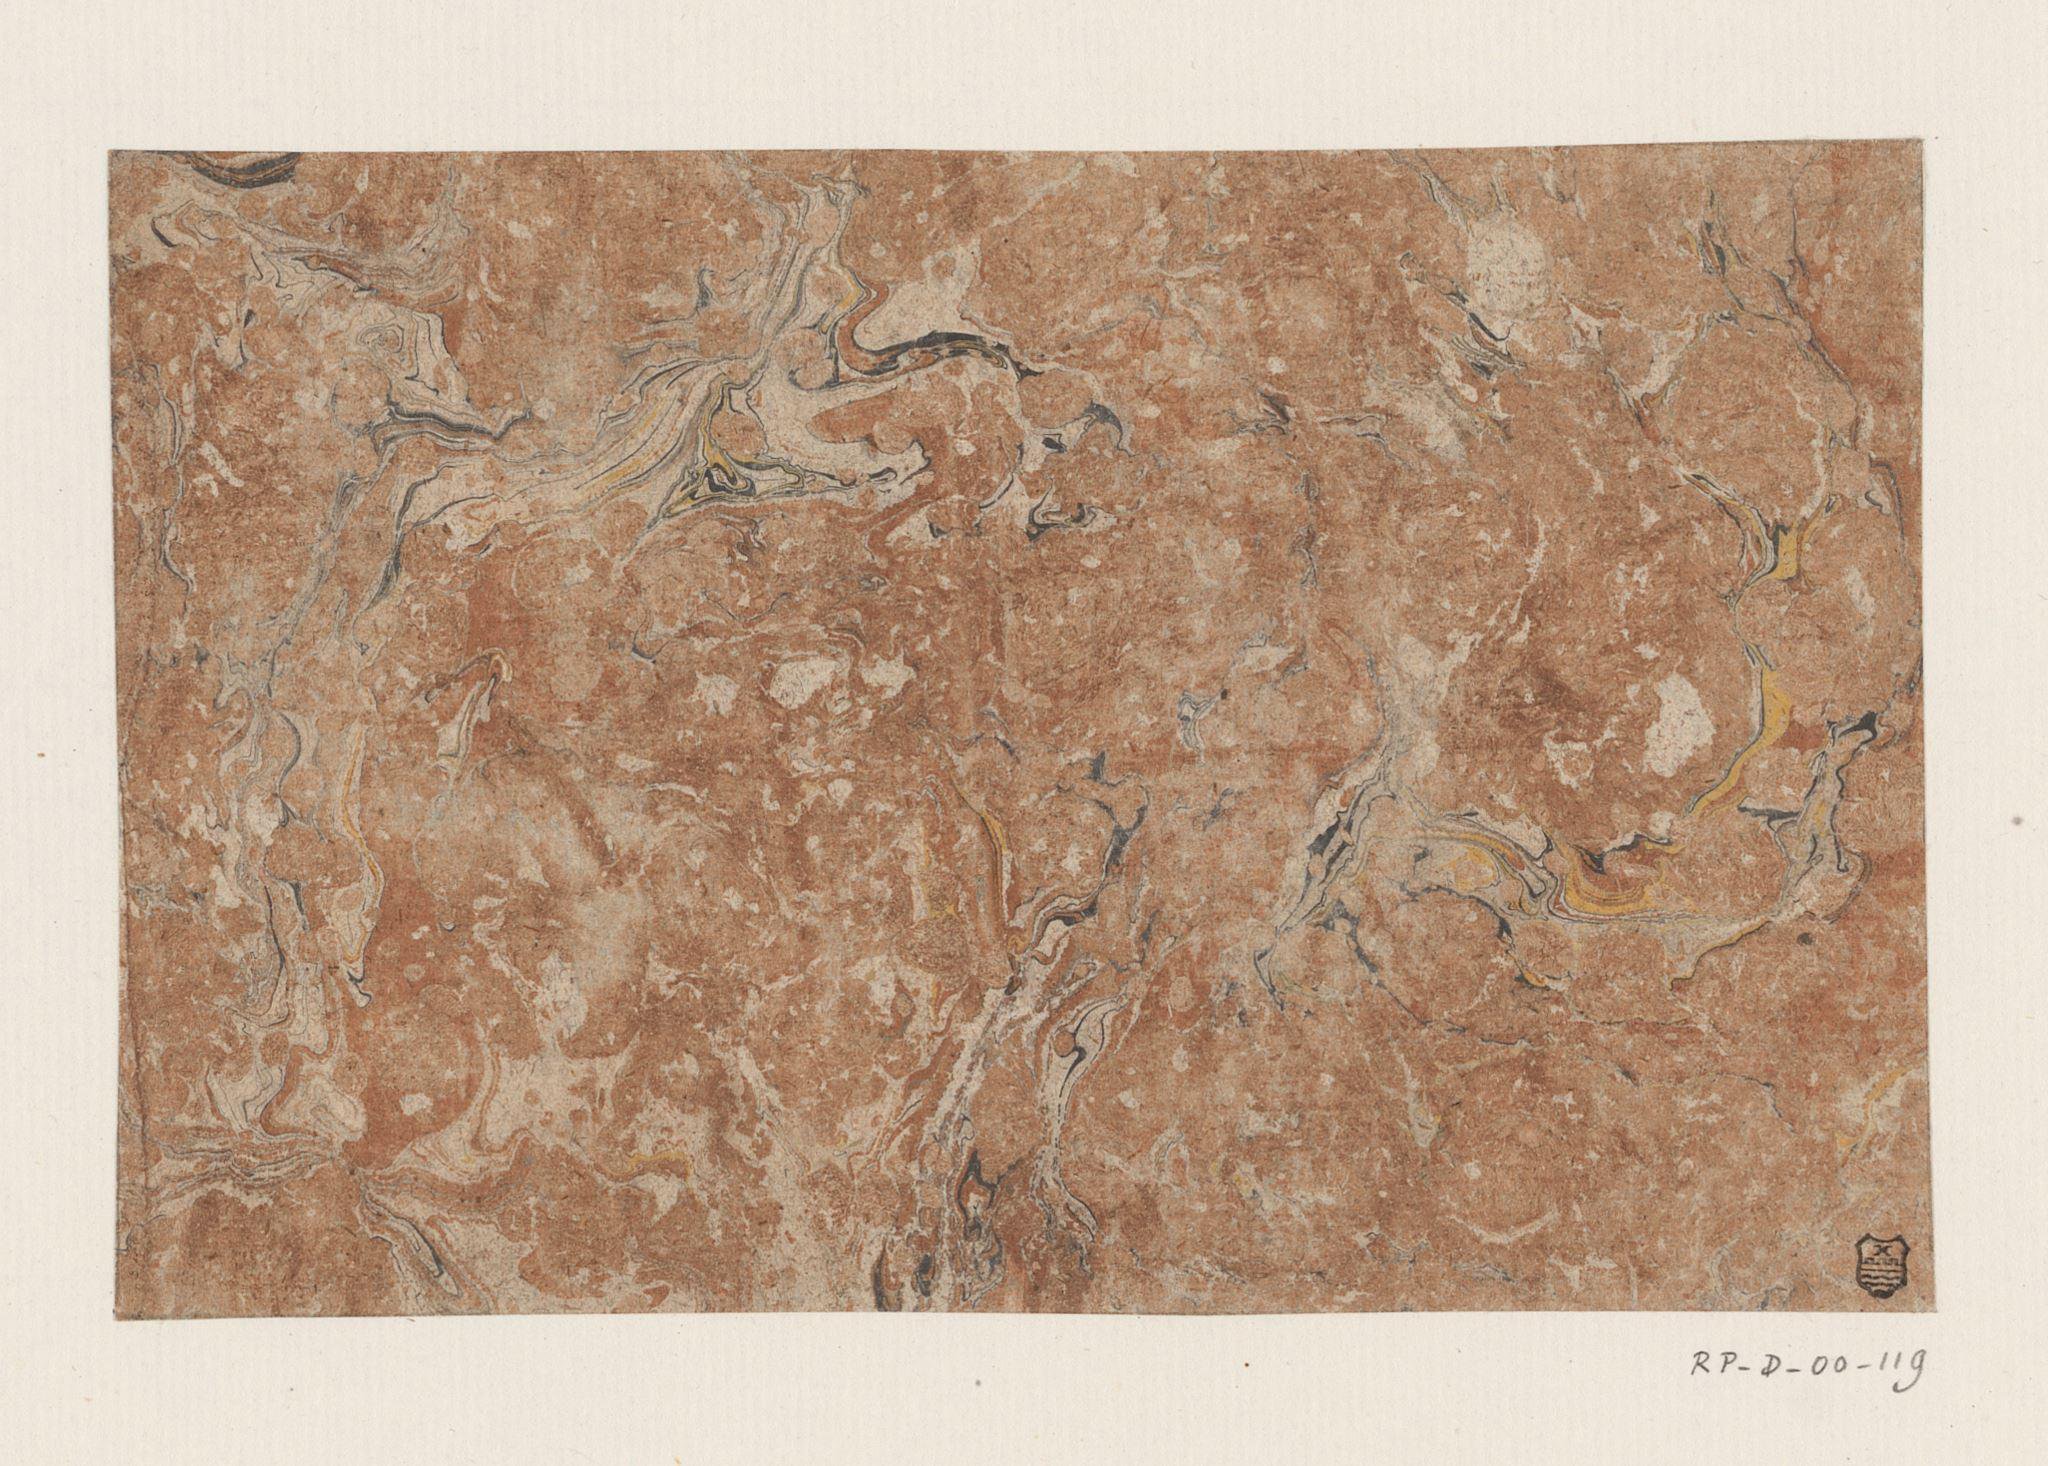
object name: marbled paper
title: Fantasie- of lussenmarmer in bruin, zwart en geel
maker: Anonymous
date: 1700-1850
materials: paint, paper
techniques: marbled paper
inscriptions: collector's mark: Lugt 2760